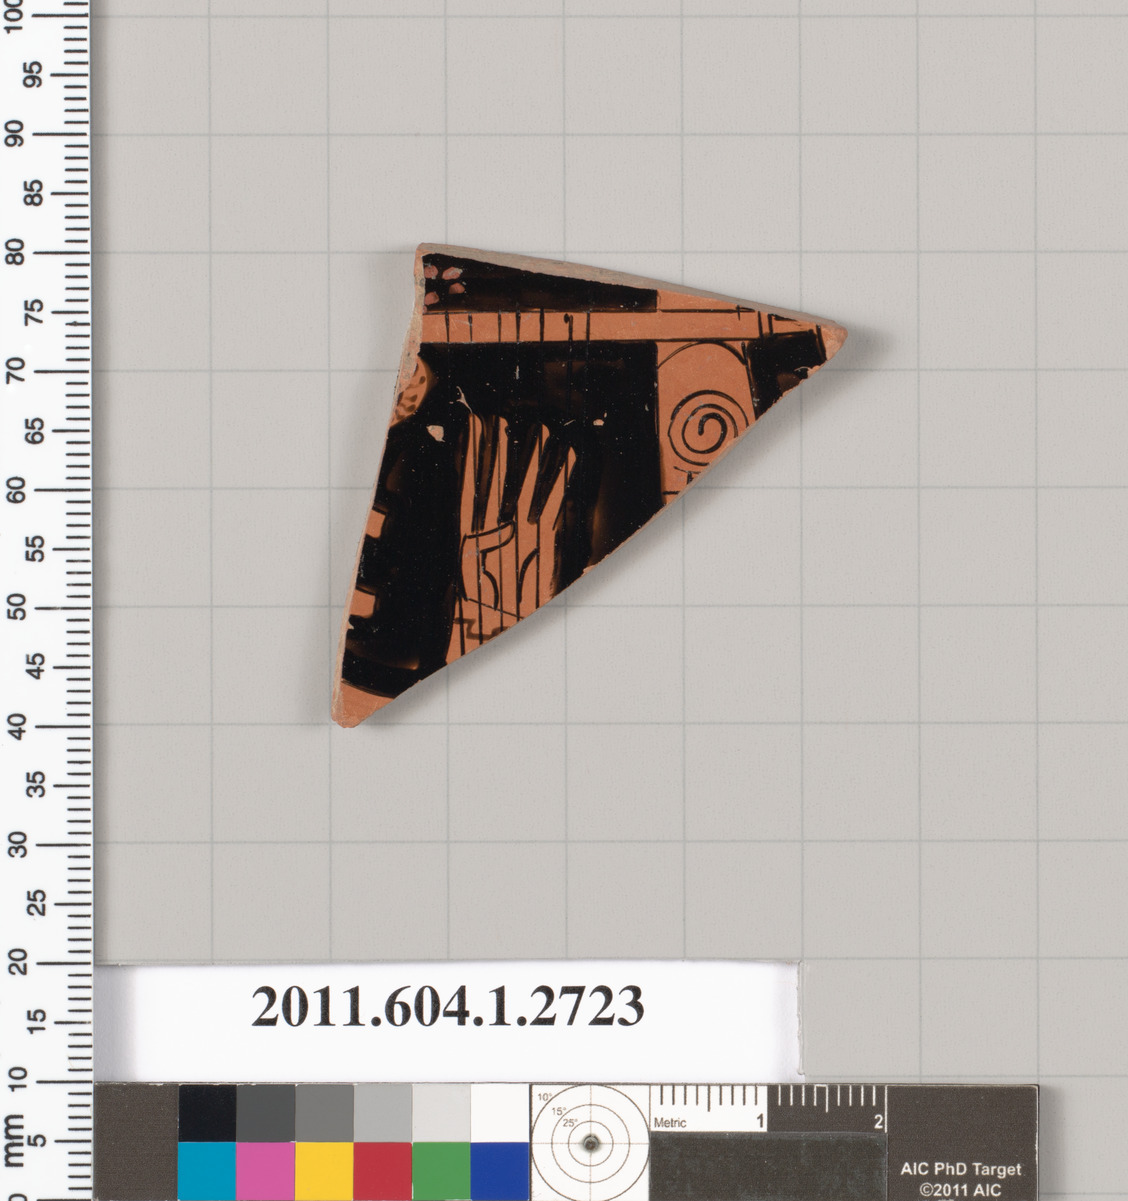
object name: kylix fragment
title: Terracotta fragment of a kylix (drinking cup)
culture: greek, attic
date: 500-476 BCE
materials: terracotta